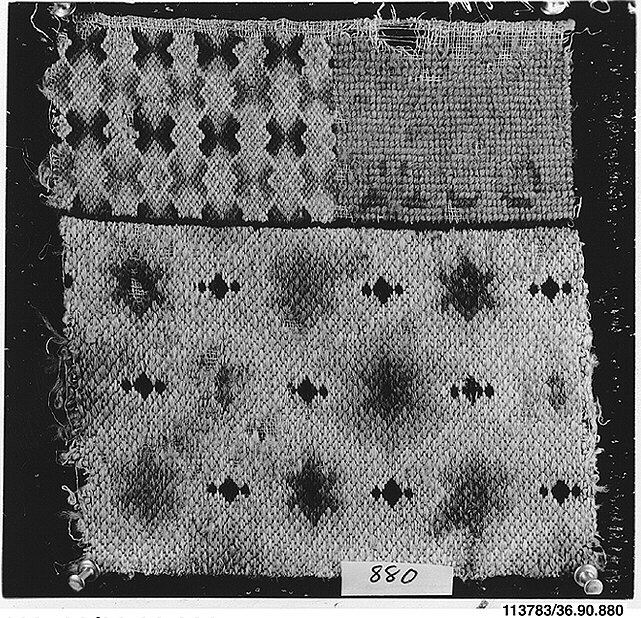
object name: sampler fragment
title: Fragment of a sampler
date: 1701-1800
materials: cotton, wool